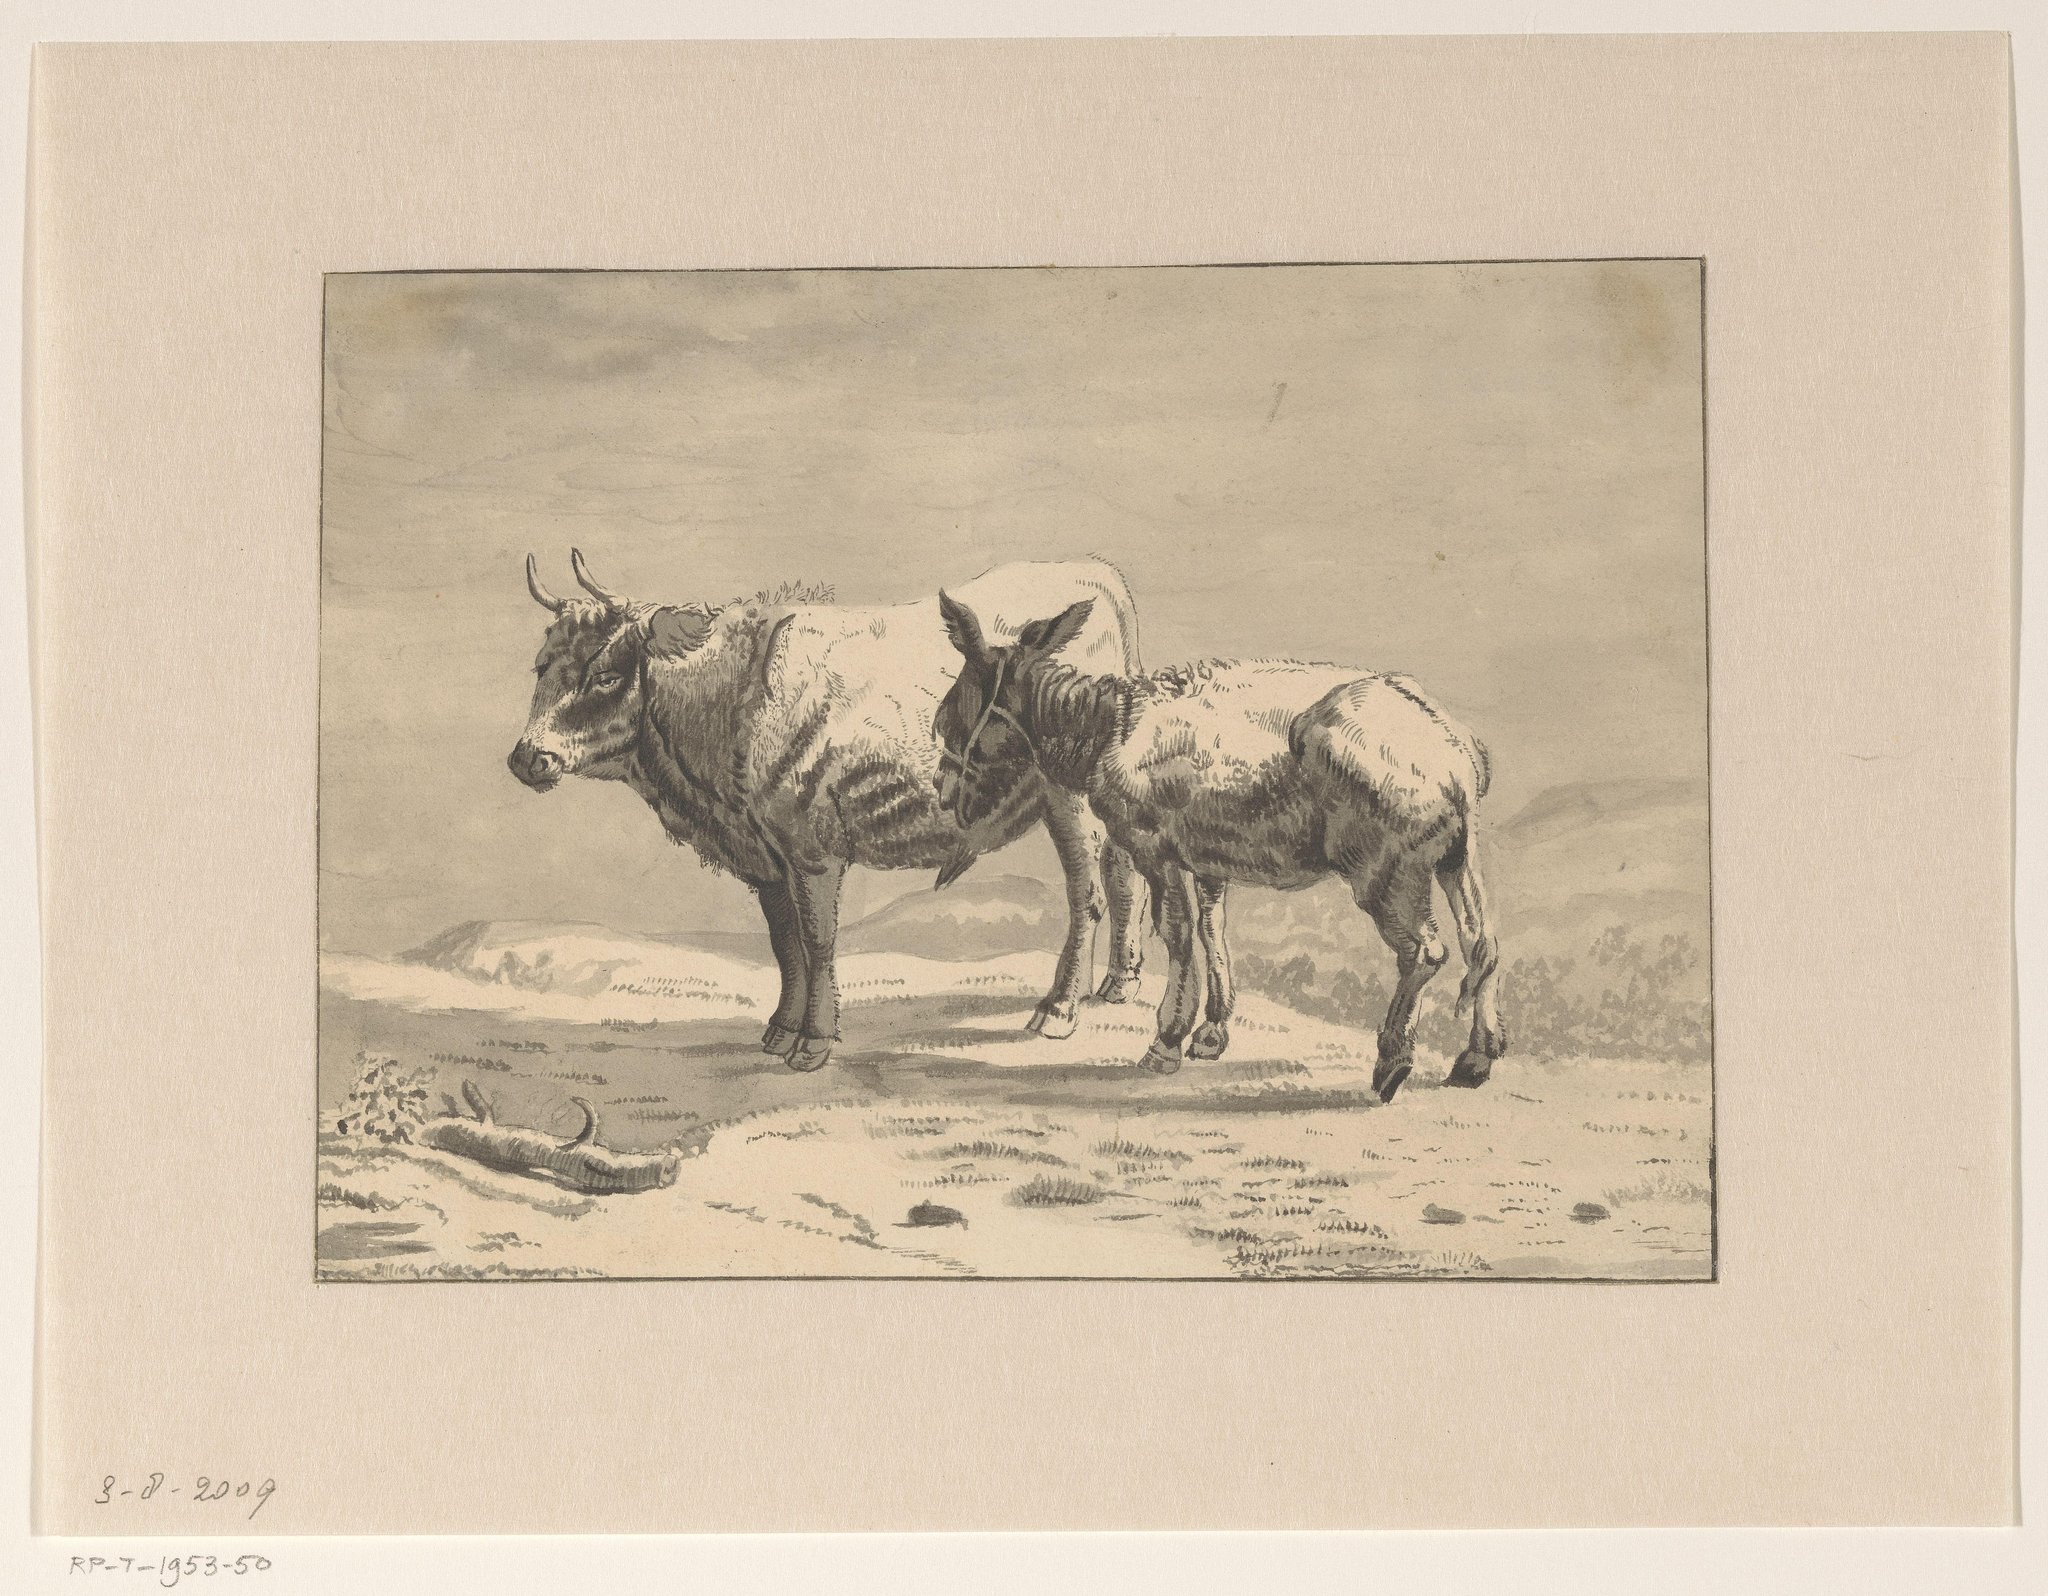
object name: drawing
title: Stier en een ezel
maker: jan bedijs tom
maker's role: draughtsman, painter, print maker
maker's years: 1813-1894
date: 1823-1894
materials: paper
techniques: brush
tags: bull, ass, donkey